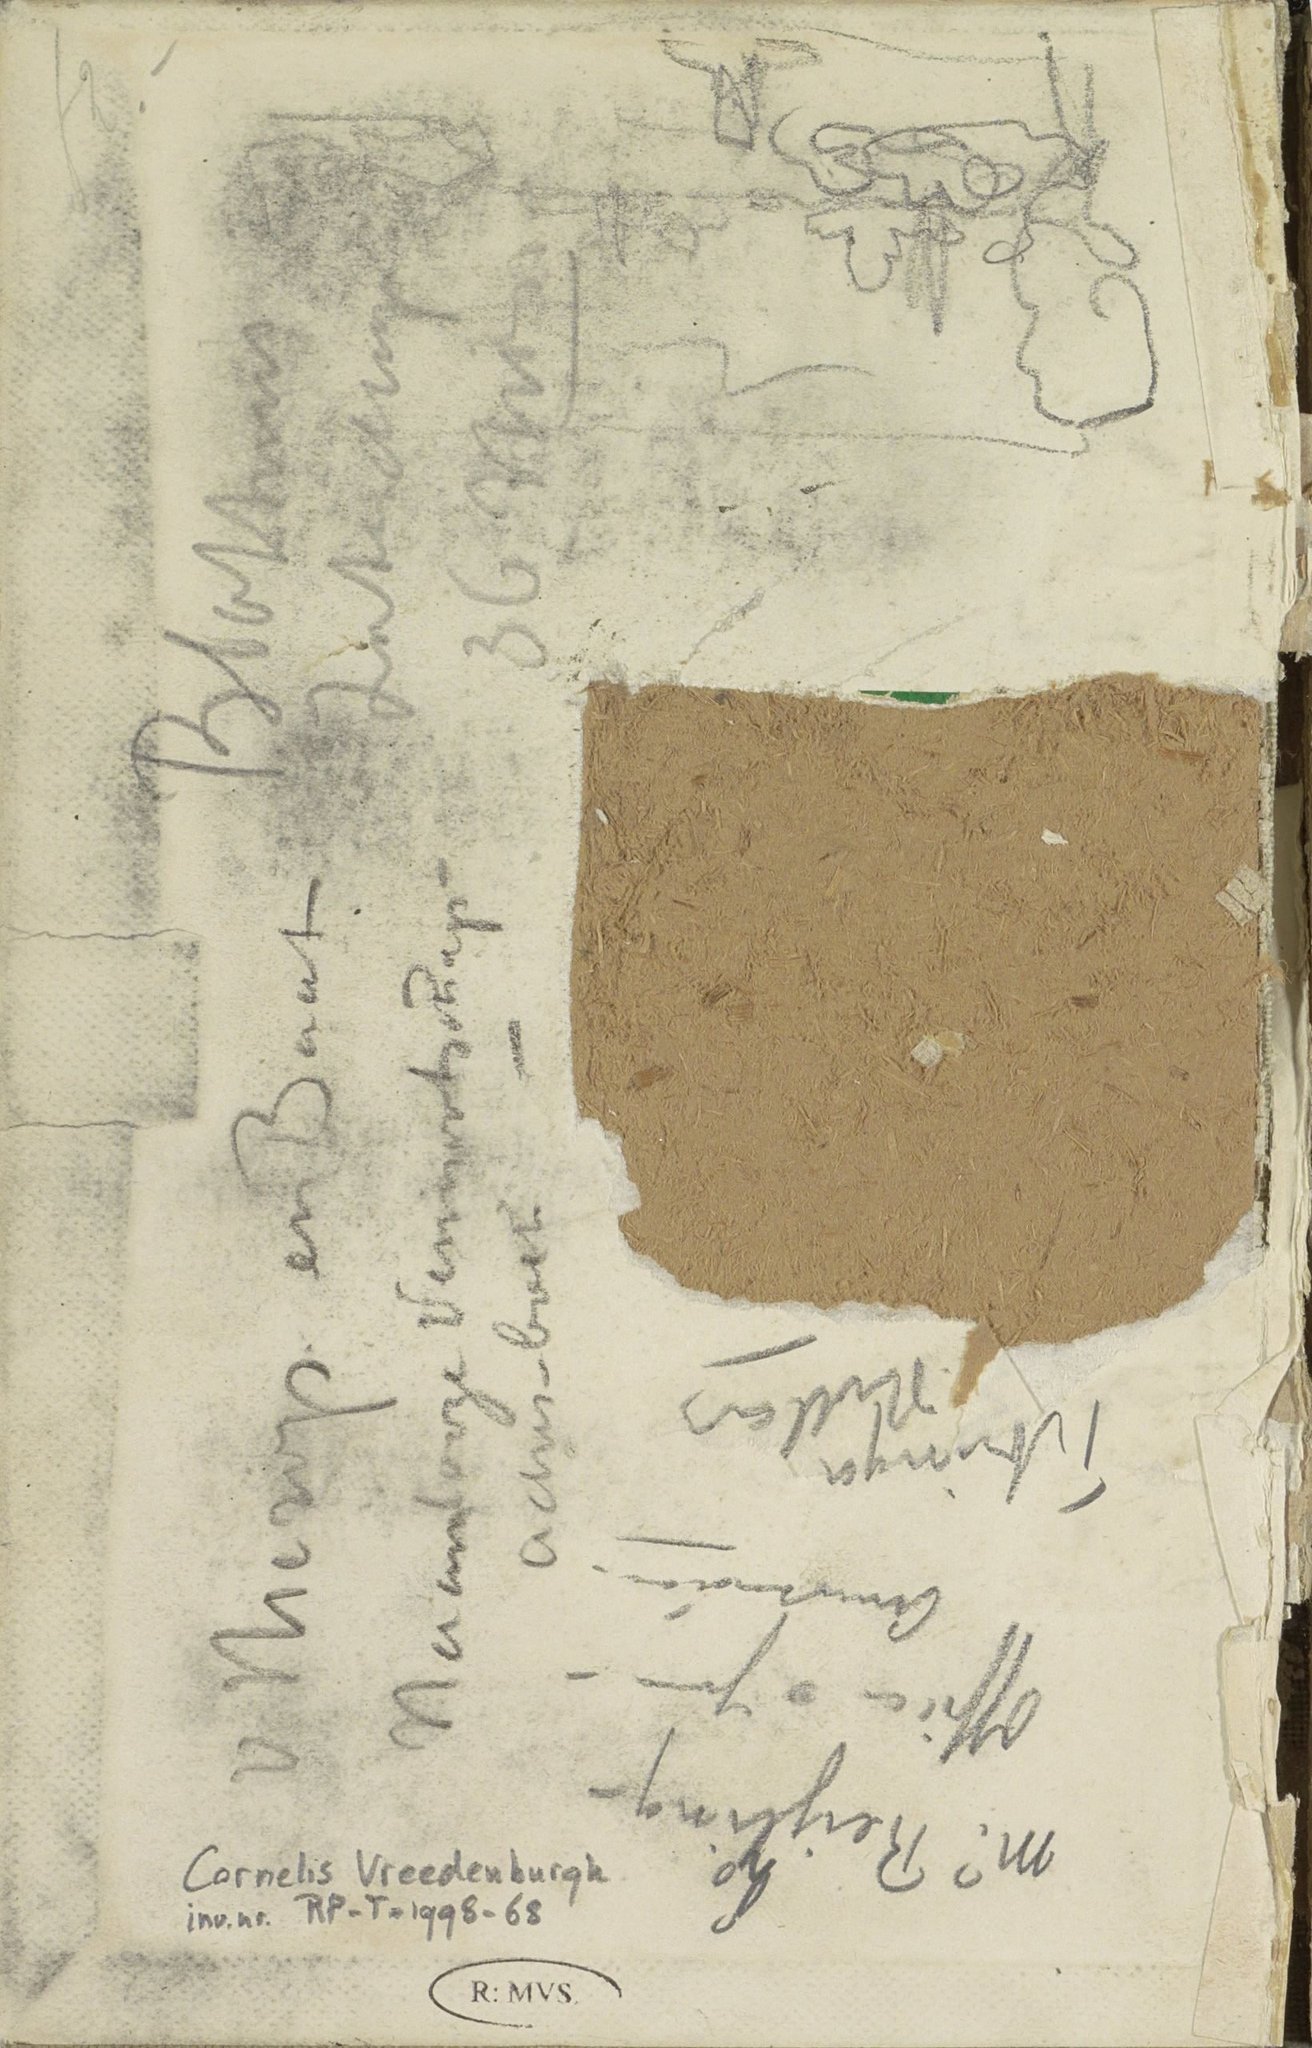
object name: sketchbook leaf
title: Landschap met water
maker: cornelis vreedenburgh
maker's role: draughtsman, print maker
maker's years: 1880-1946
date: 1890-1946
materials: paper, pencil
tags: landscapes with waters, waterscapes, seascapes (in the temperate zone)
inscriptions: collector's mark: Lugt 2228a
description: Voorste schutblad uit een schetsboek met 56 bladen.